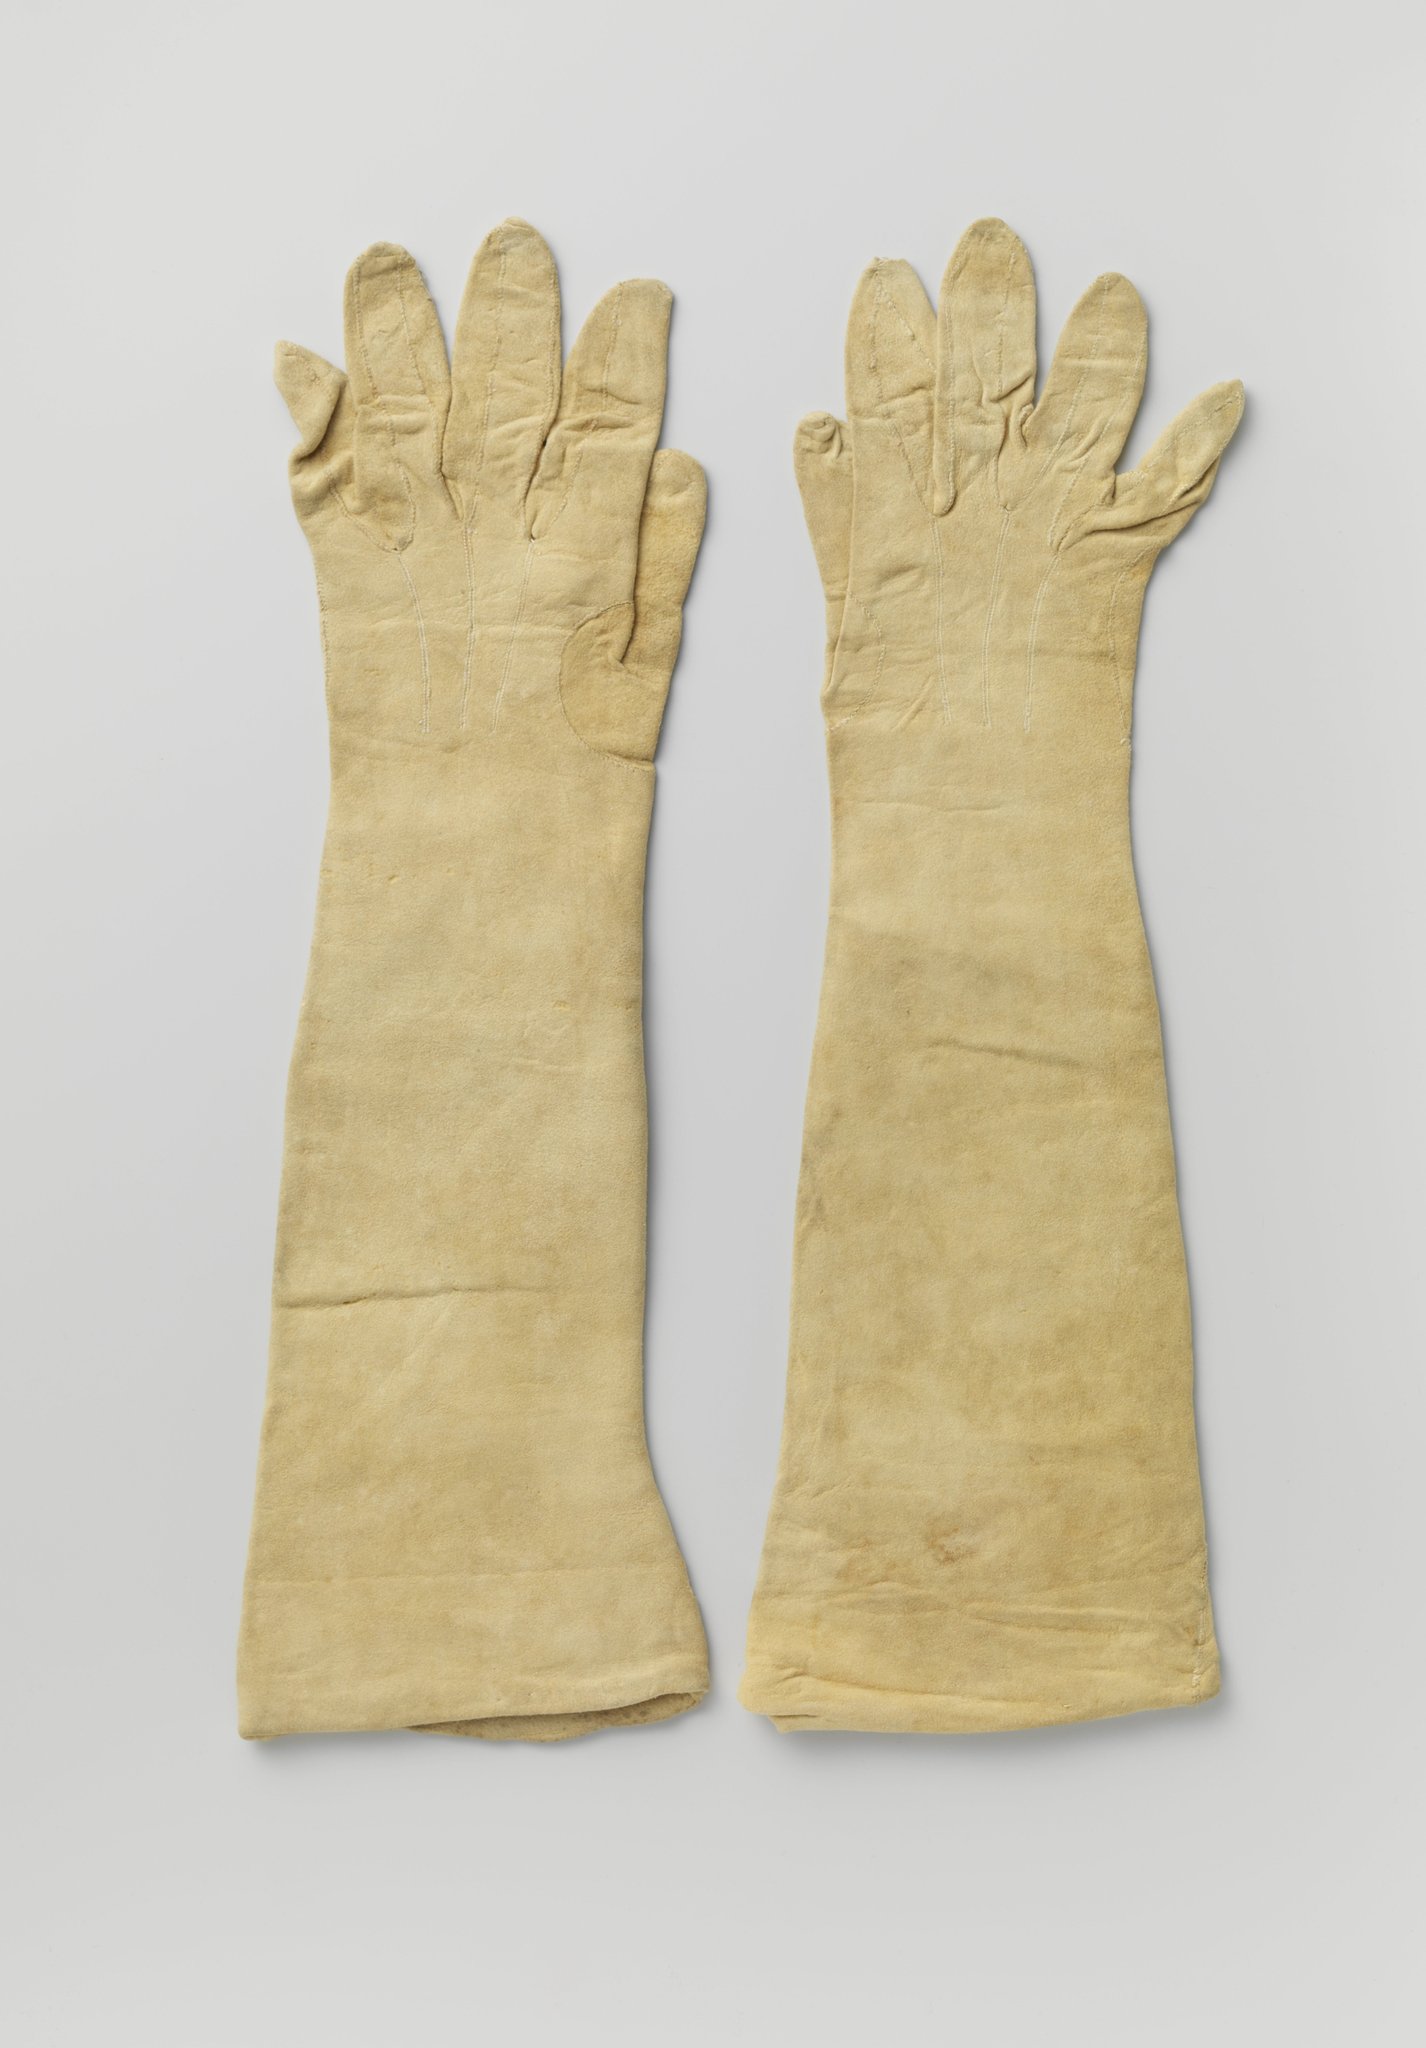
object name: glove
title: Rechterhandschoen van naturel zeemleer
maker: Anonymous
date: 1900-1925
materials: leather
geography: netherlands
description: Rechterhandschoen van naturel zeemleer, op de rug drie uitstralende koorden.